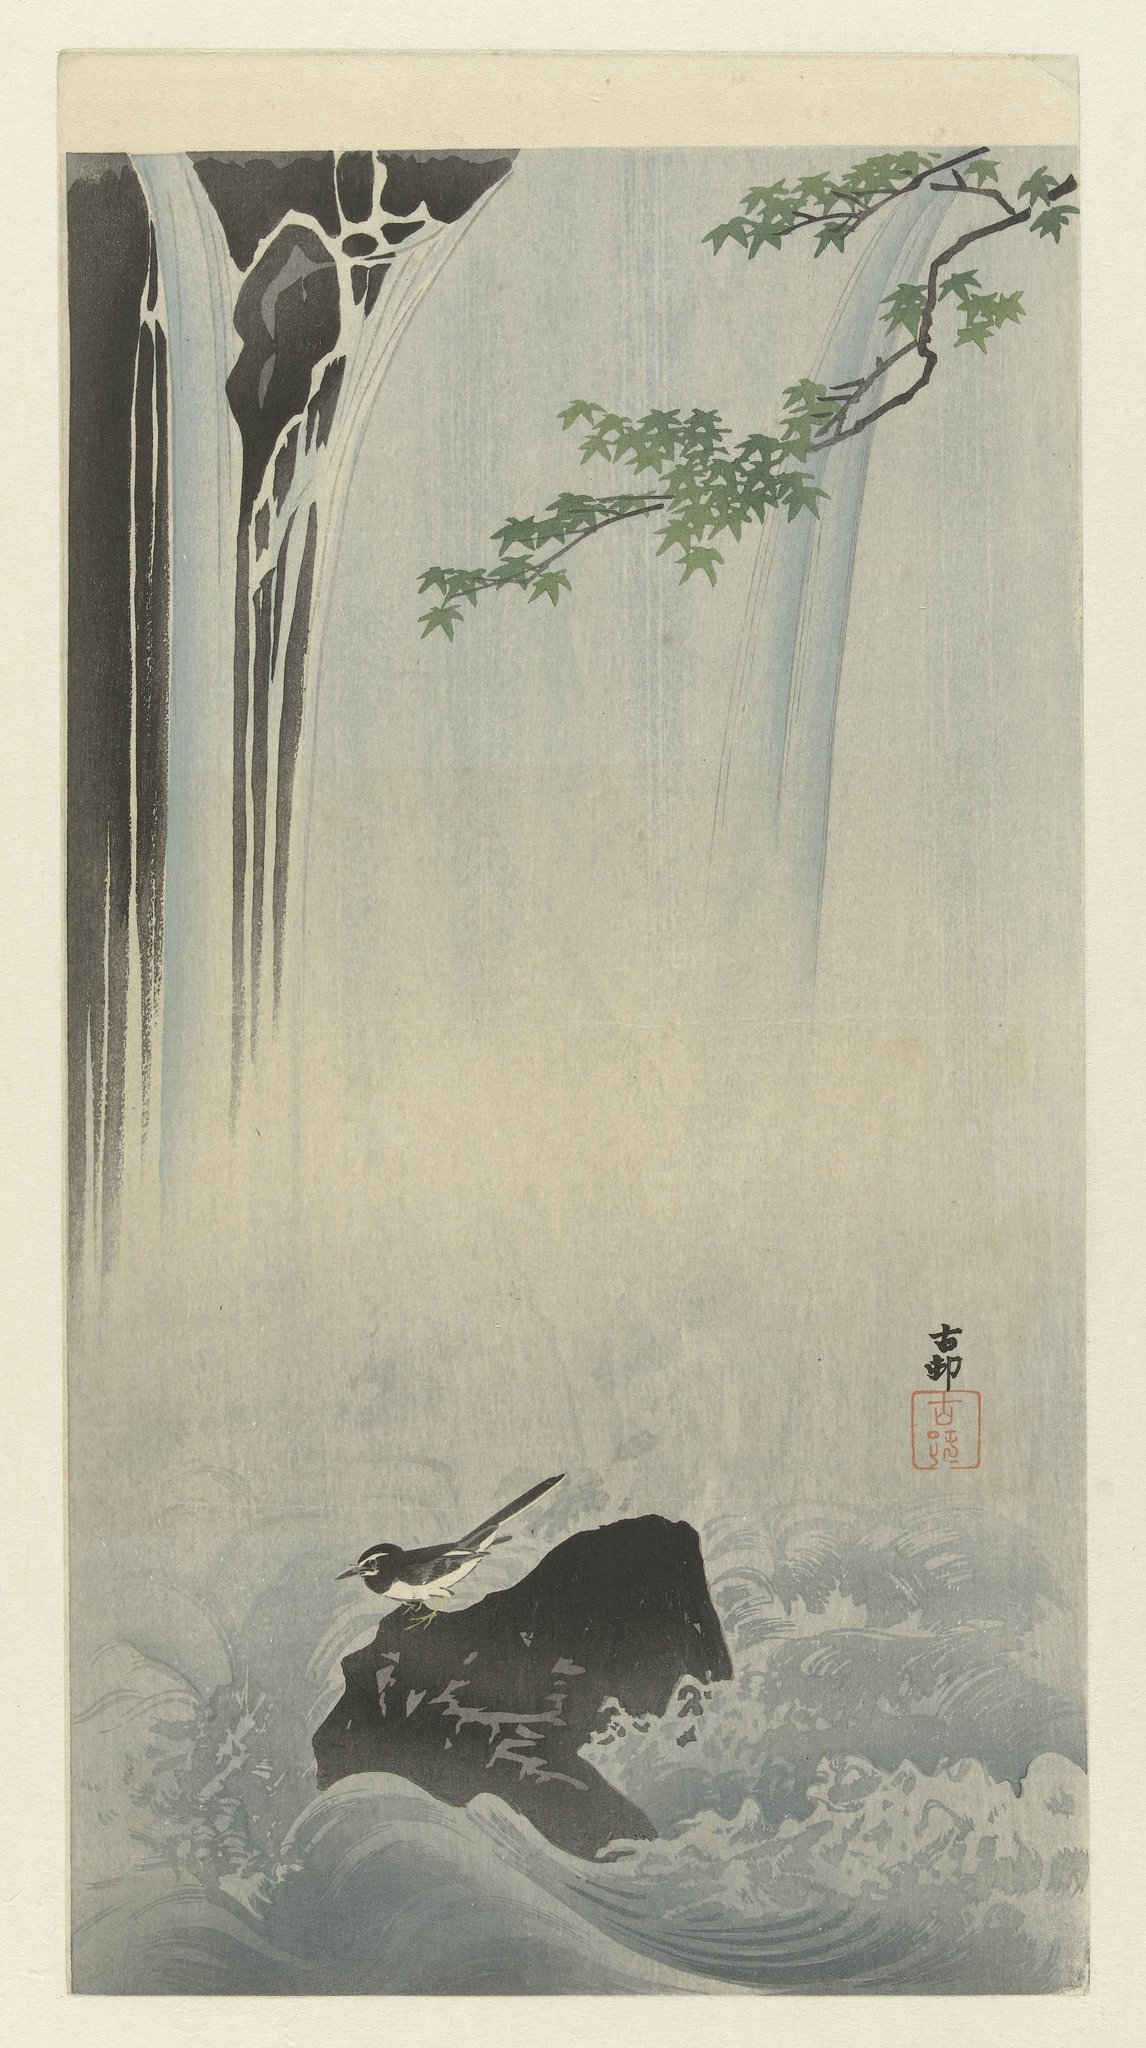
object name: print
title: Japanse kwikstaart bij waterval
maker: ohara koson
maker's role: print maker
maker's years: 1877-1945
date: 1900-1930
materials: paper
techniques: woodcut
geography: tokyo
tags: birds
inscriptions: collector's mark: Lugt 2228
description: Zwart-wit vogeltje op rots in woelig water onderaan waterval. Rechtsboven esdoorntak.